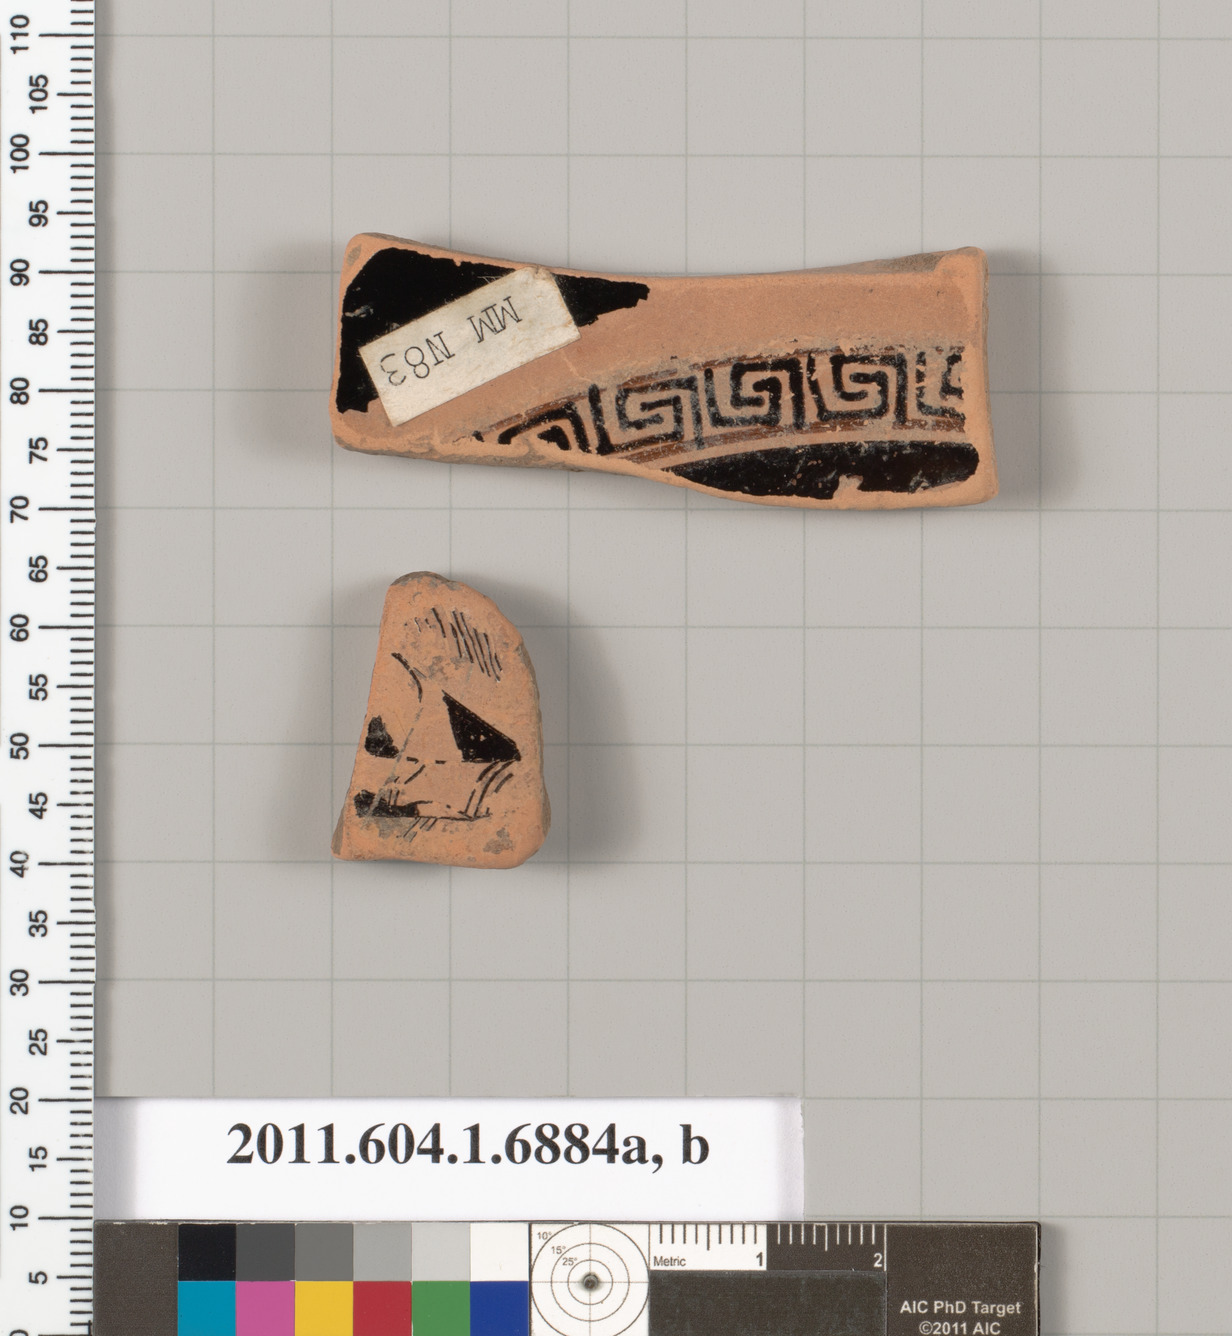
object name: kylix fragment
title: Terracotta fragments of a kylix (drinking cup)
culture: greek, attic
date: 490-470 BCE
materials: terracotta